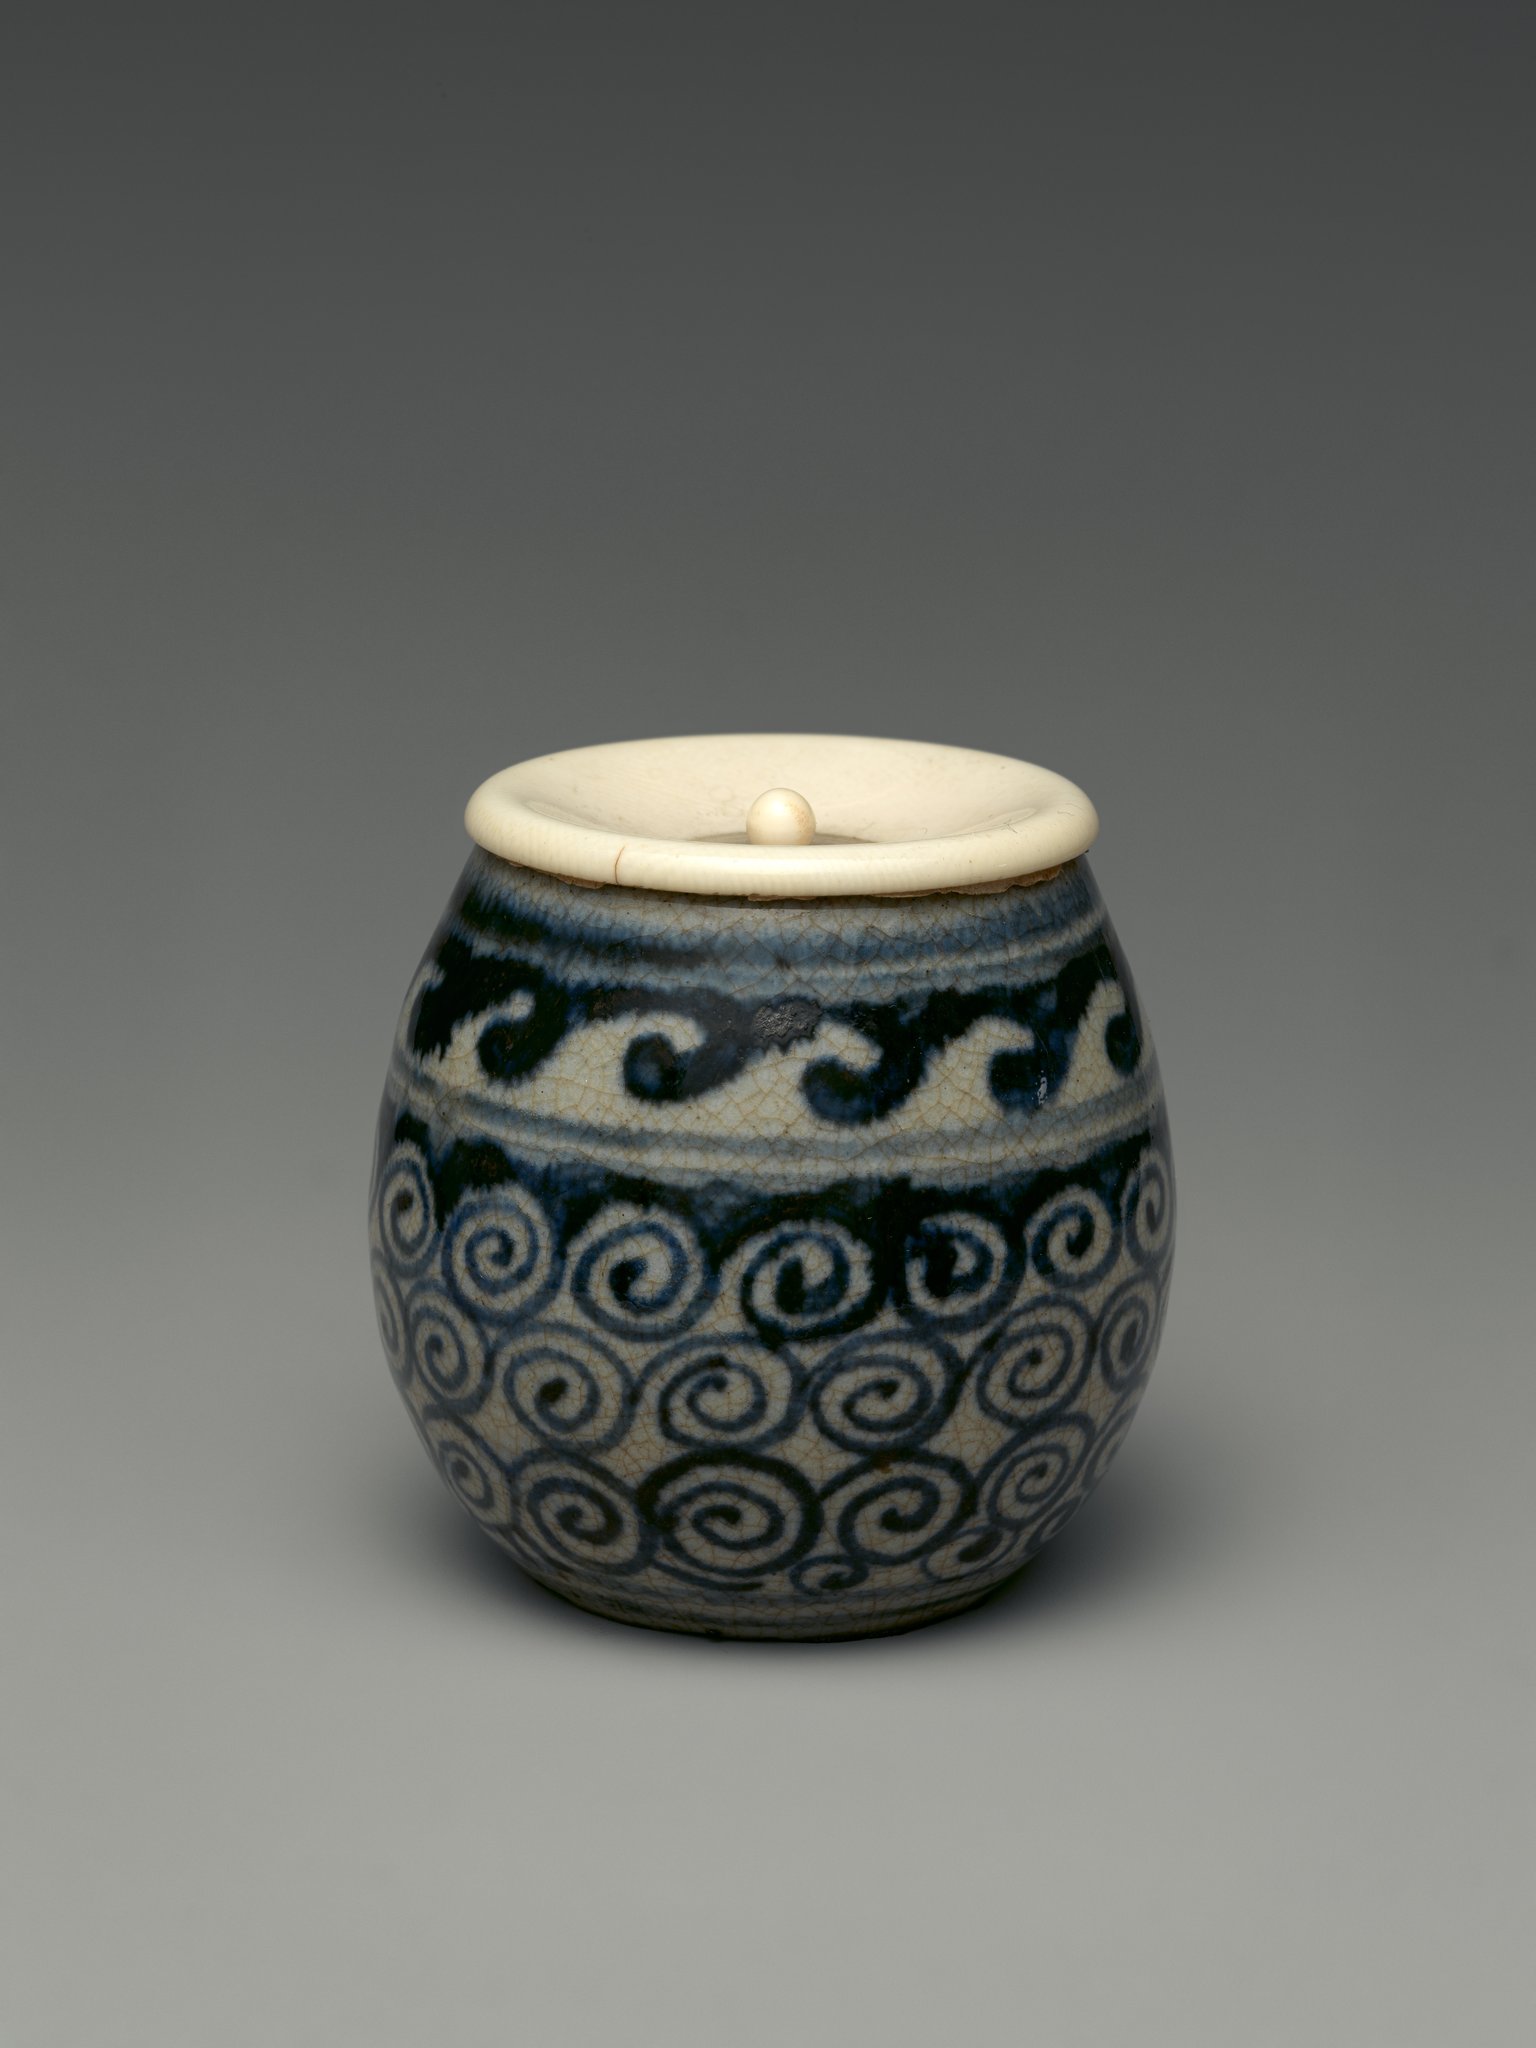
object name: tea caddy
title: Tea Caddy (Chaire)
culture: japanese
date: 1801-1850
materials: ivory, porcelain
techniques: underglaze